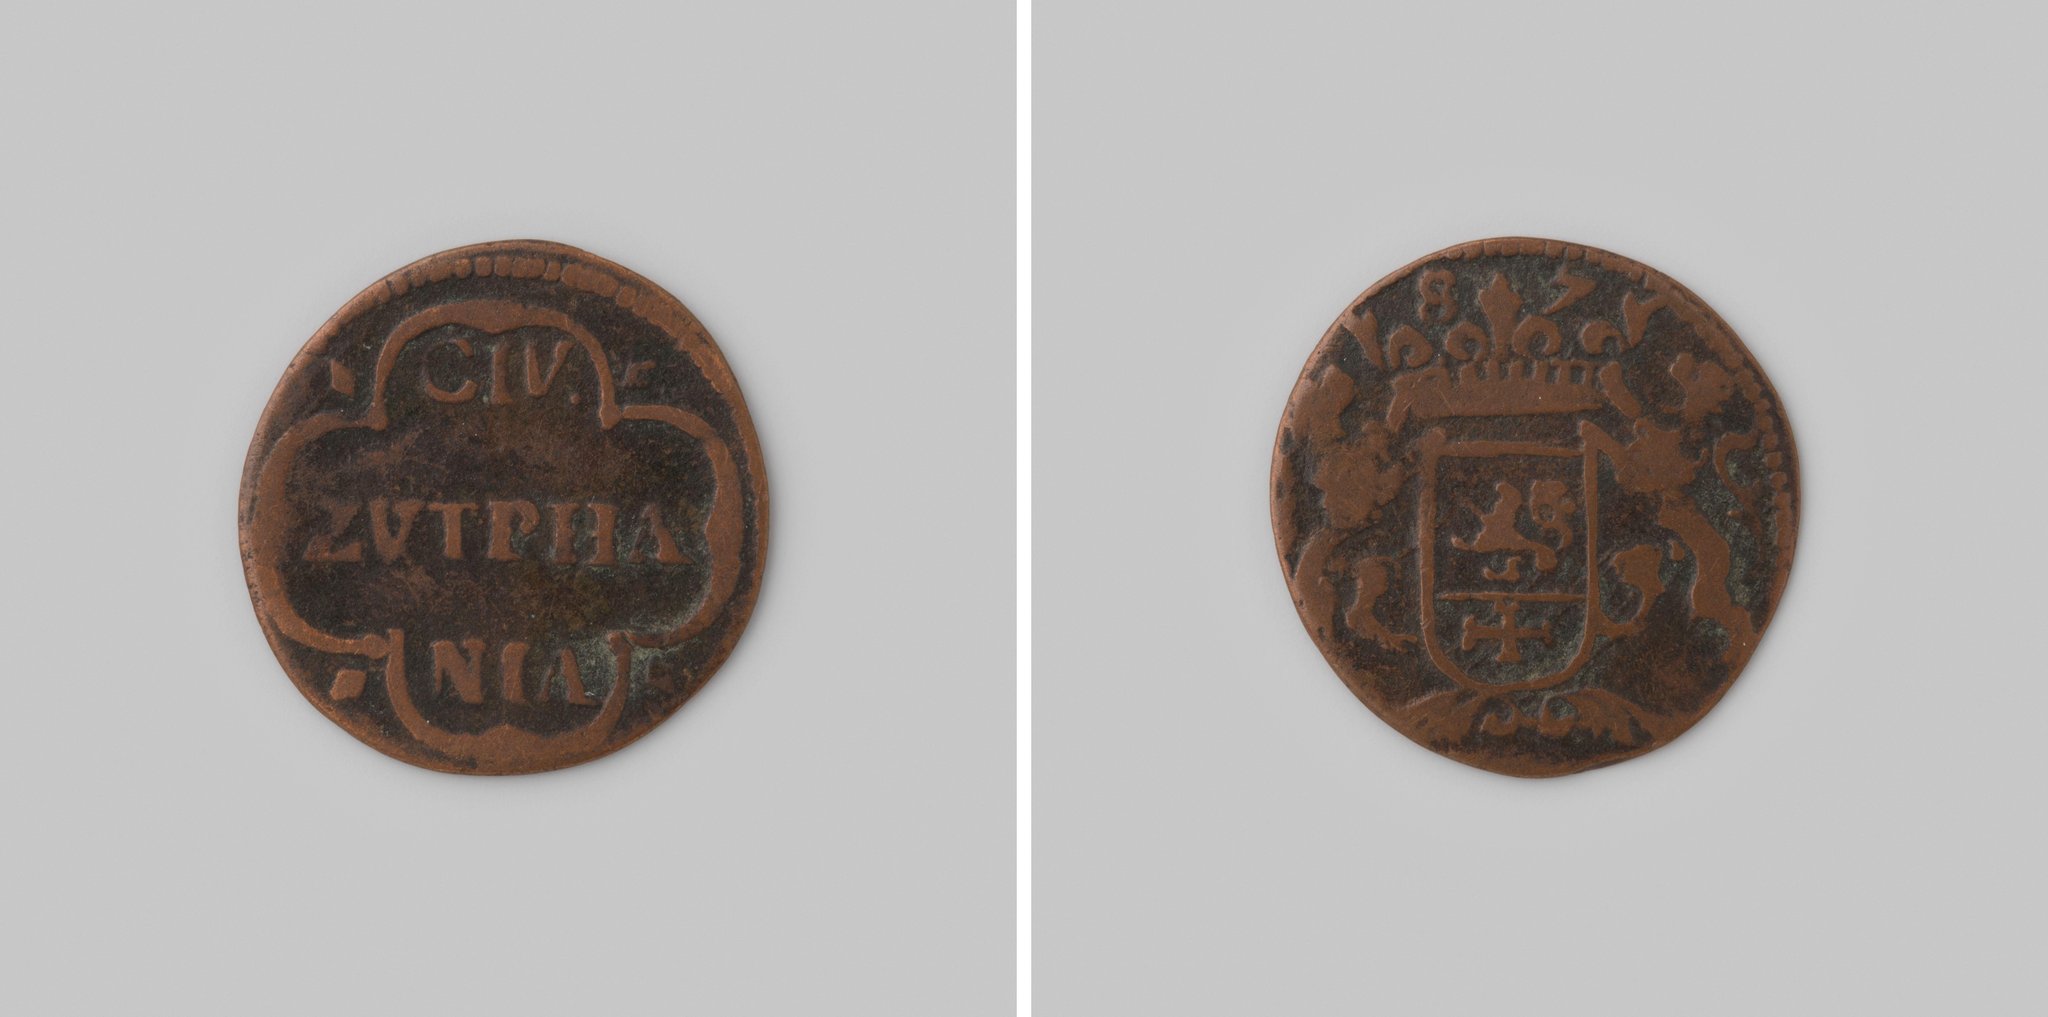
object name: coin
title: Zutphense duit, 1687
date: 1687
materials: copper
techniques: striking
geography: zutphen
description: Koperen munt. Voorzijde: in een vierpas opschrift: stadsnaam in drie regels. Keerzijde: op versiering door twee leeuwen gehouden gekroond wapenschild van Zutphen.